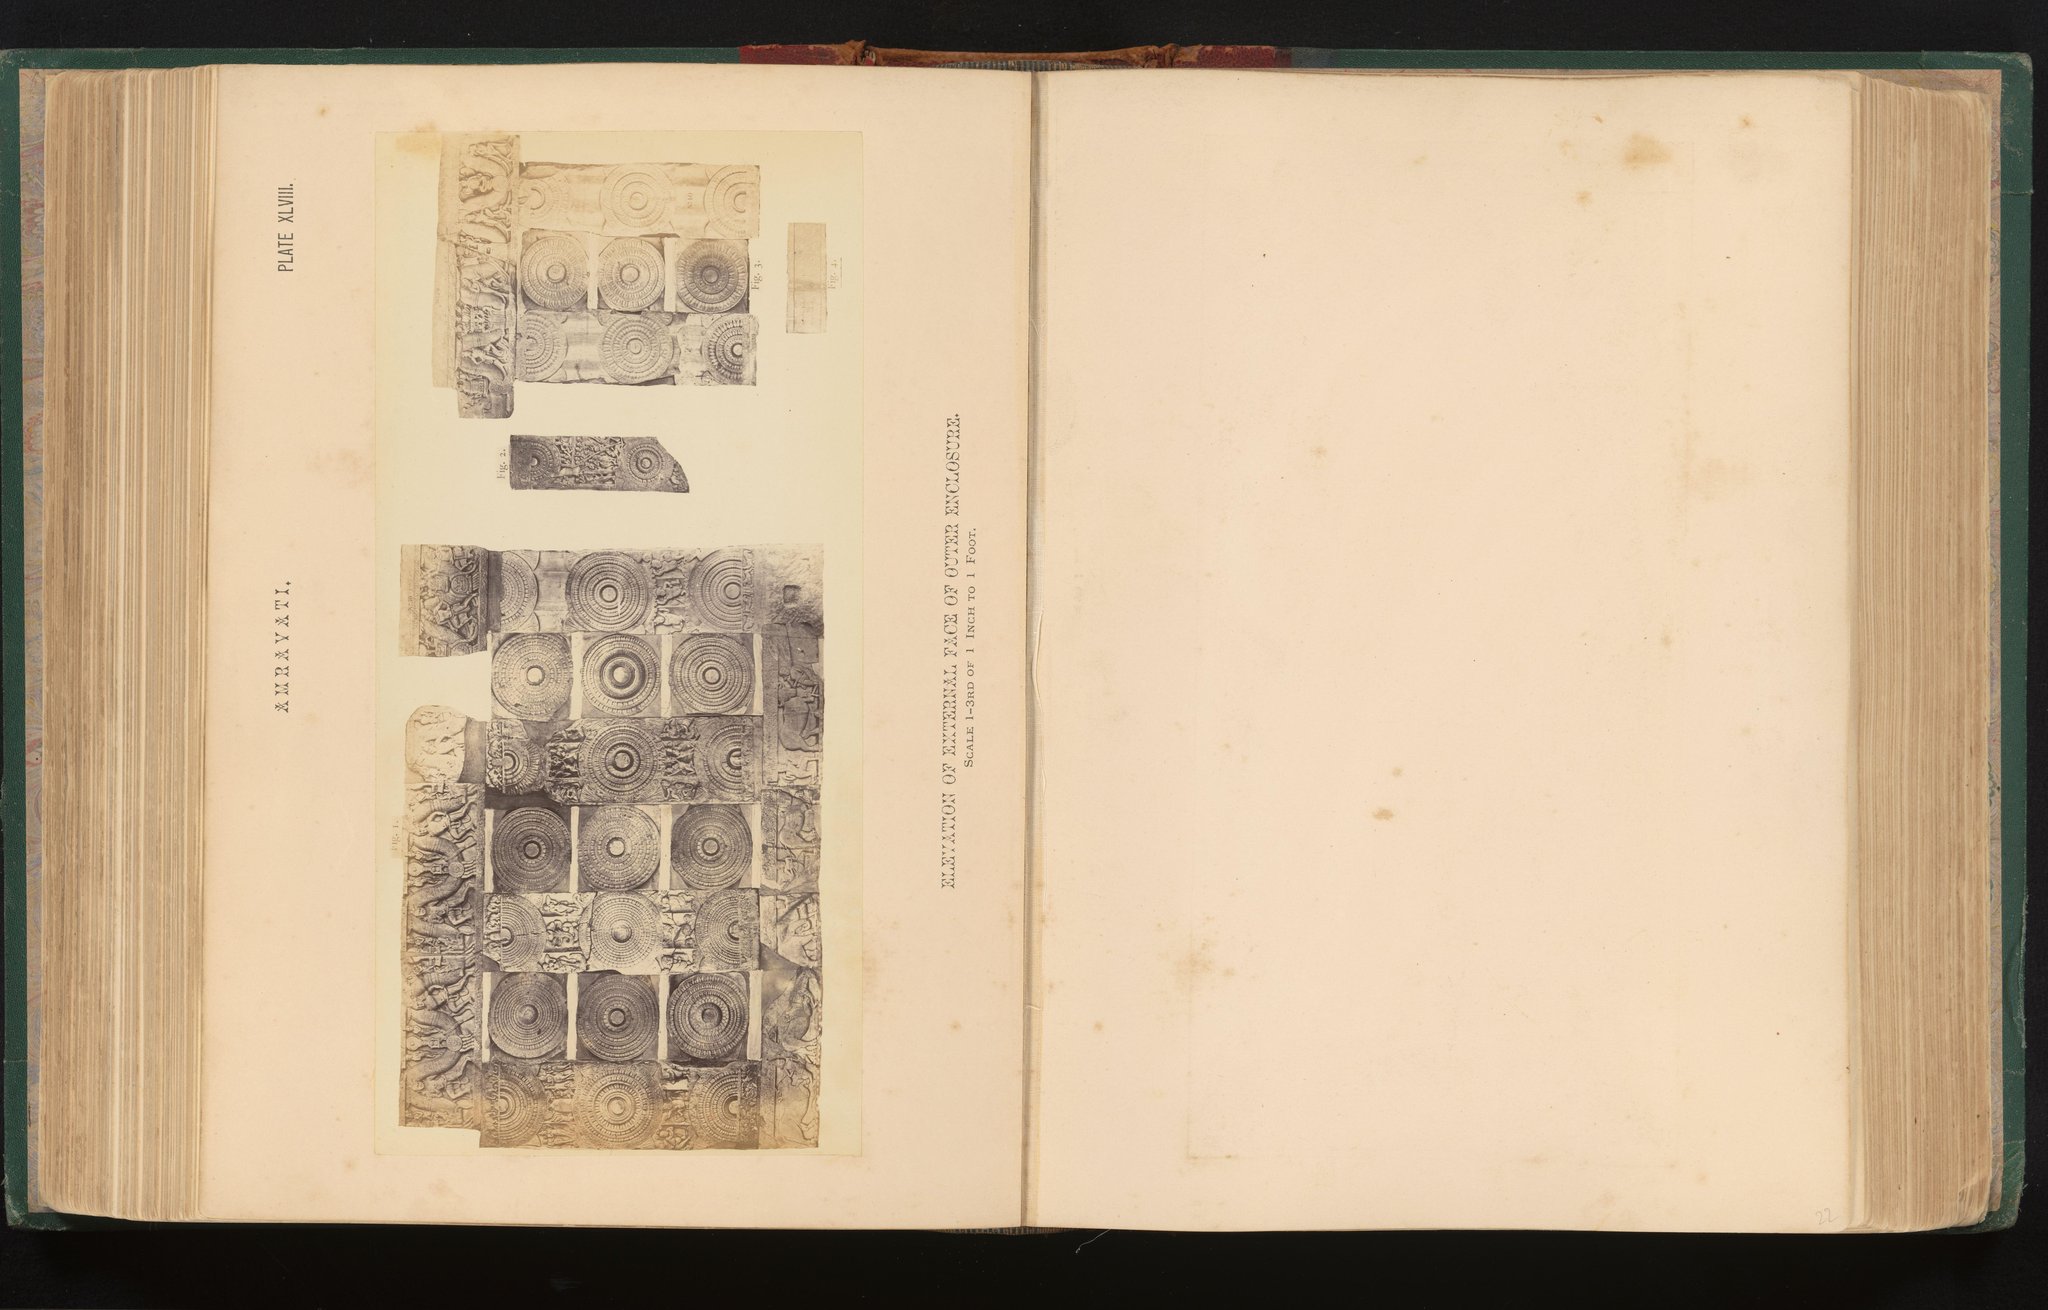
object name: photograph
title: Plate with four images of an enclosure at Amaravati, Andhra Pradesh, India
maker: Anonymous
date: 1863-1868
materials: photographic support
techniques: albumen print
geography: amaravati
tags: hinduism, buddhism, jainism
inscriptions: inscription: ‘AMRAVATI. Plate XLVIII.’, inscription: ‘ELEVATION OF EXTERNAL FACE OF OUTER ENCLOSURE./ SCALE 1=3RD OF 1 INCH TO 1 FOOT.’